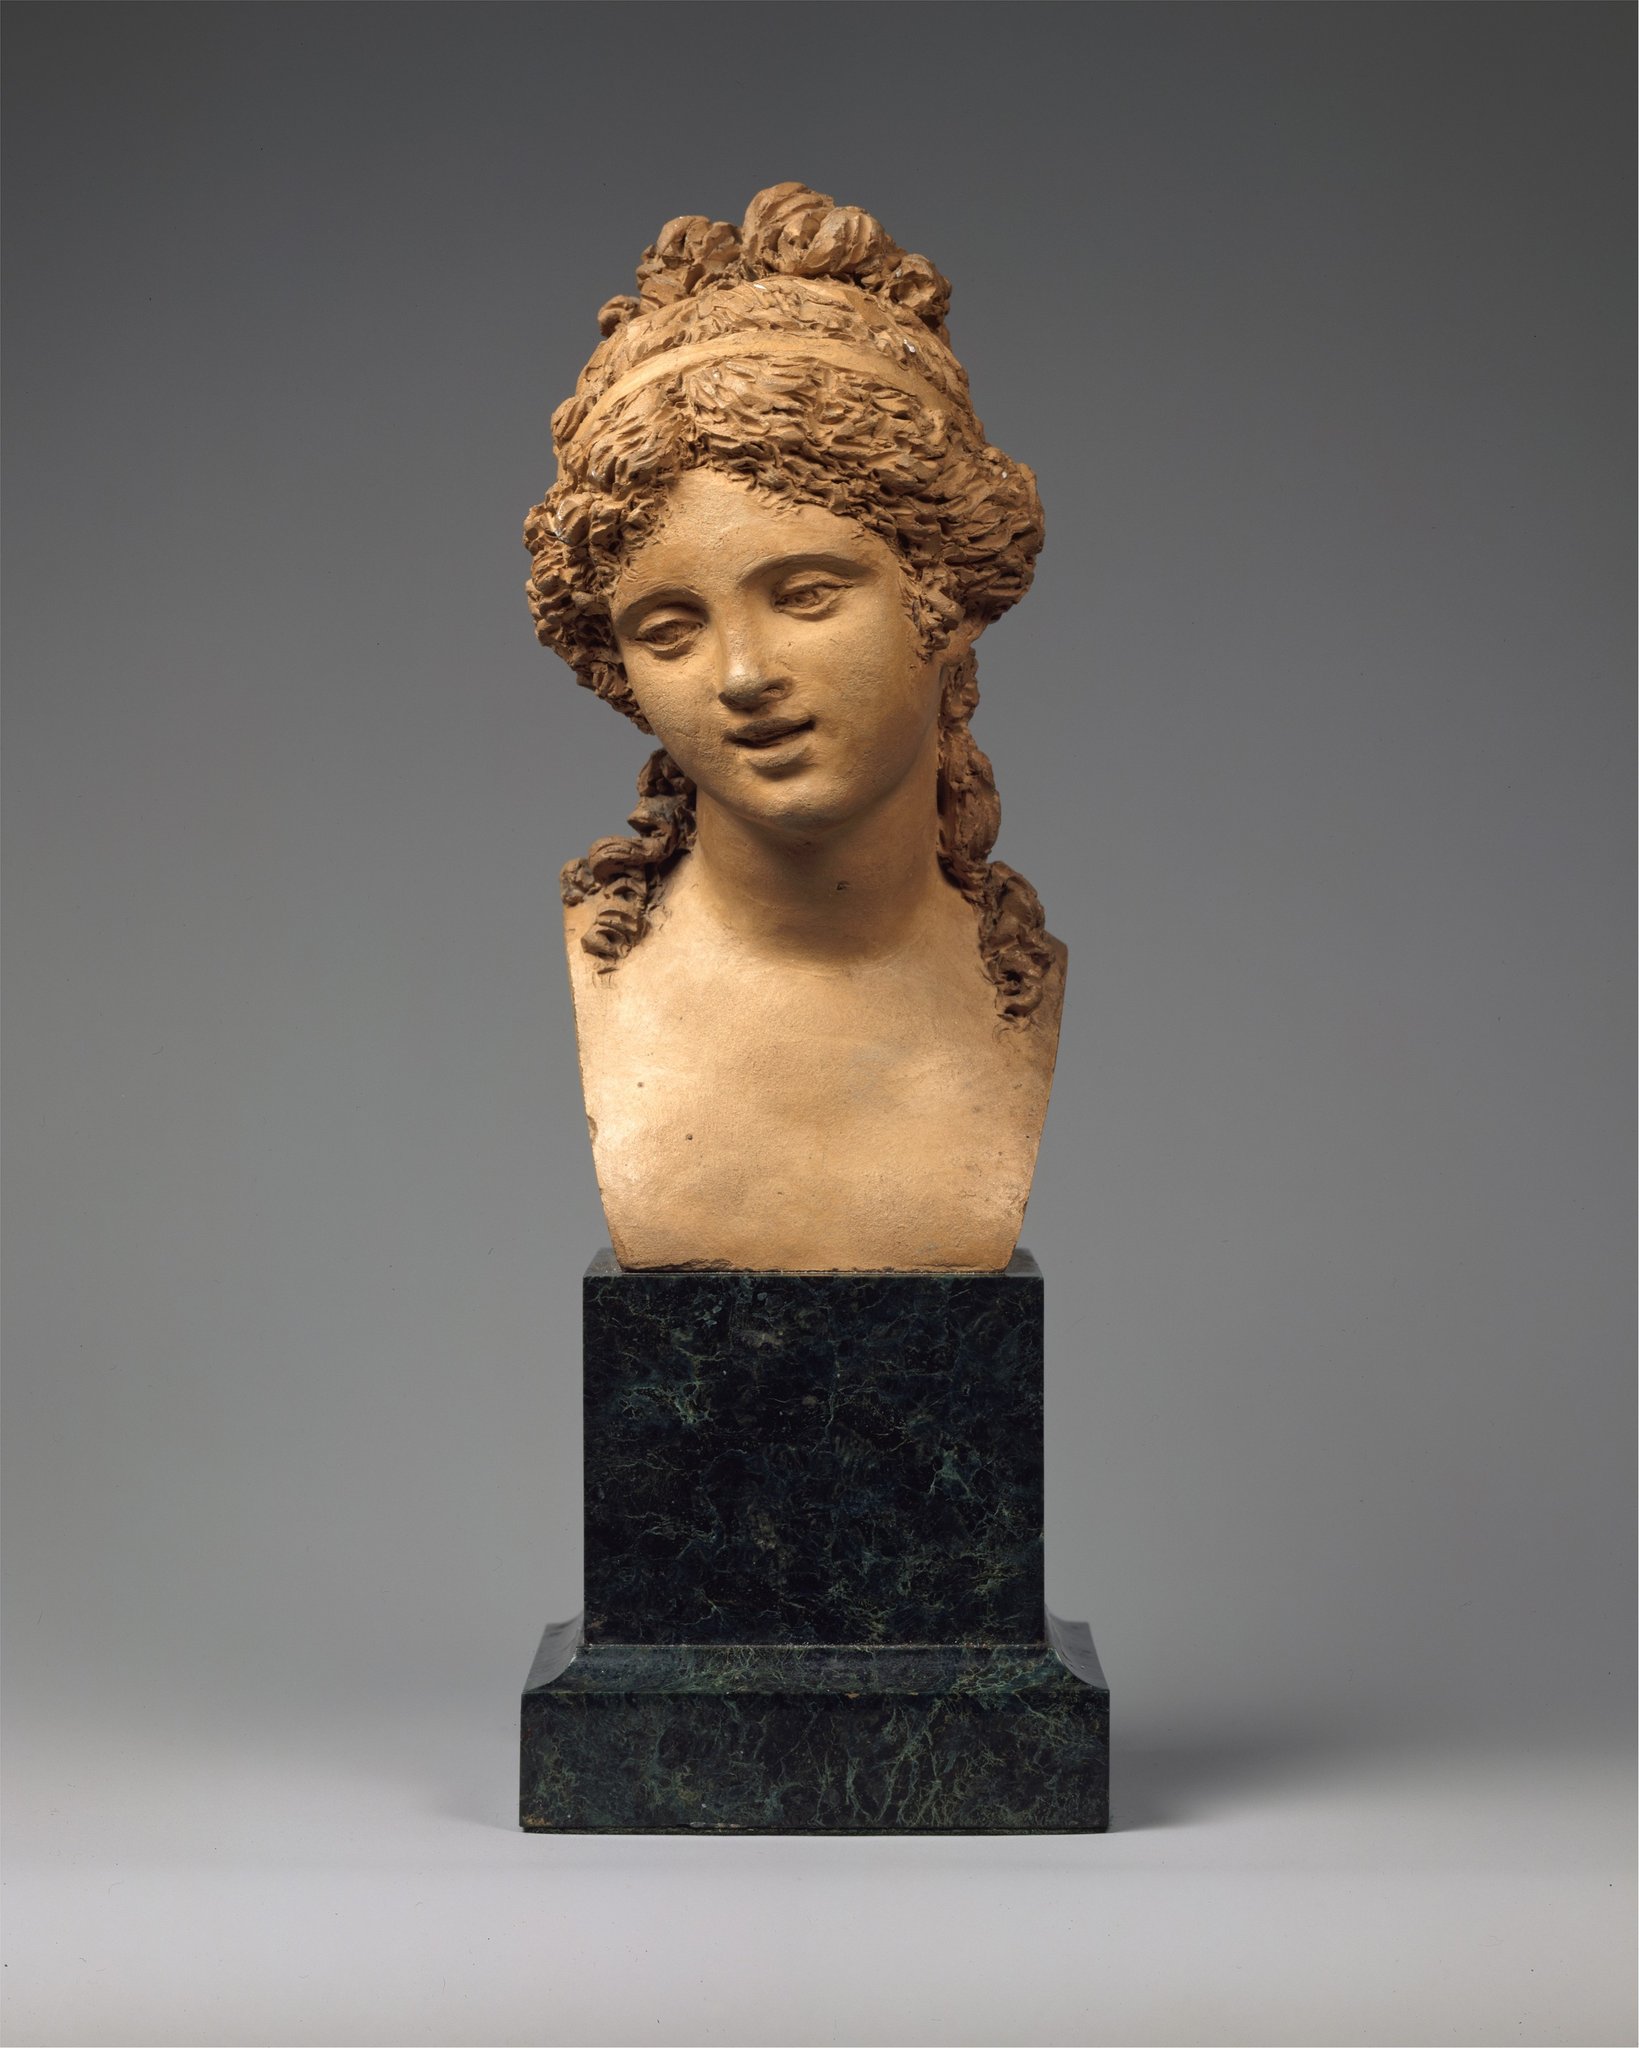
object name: bust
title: Female Bust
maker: joseph-charles marin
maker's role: artist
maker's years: 1759-1834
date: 1795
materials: marble, terracotta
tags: women